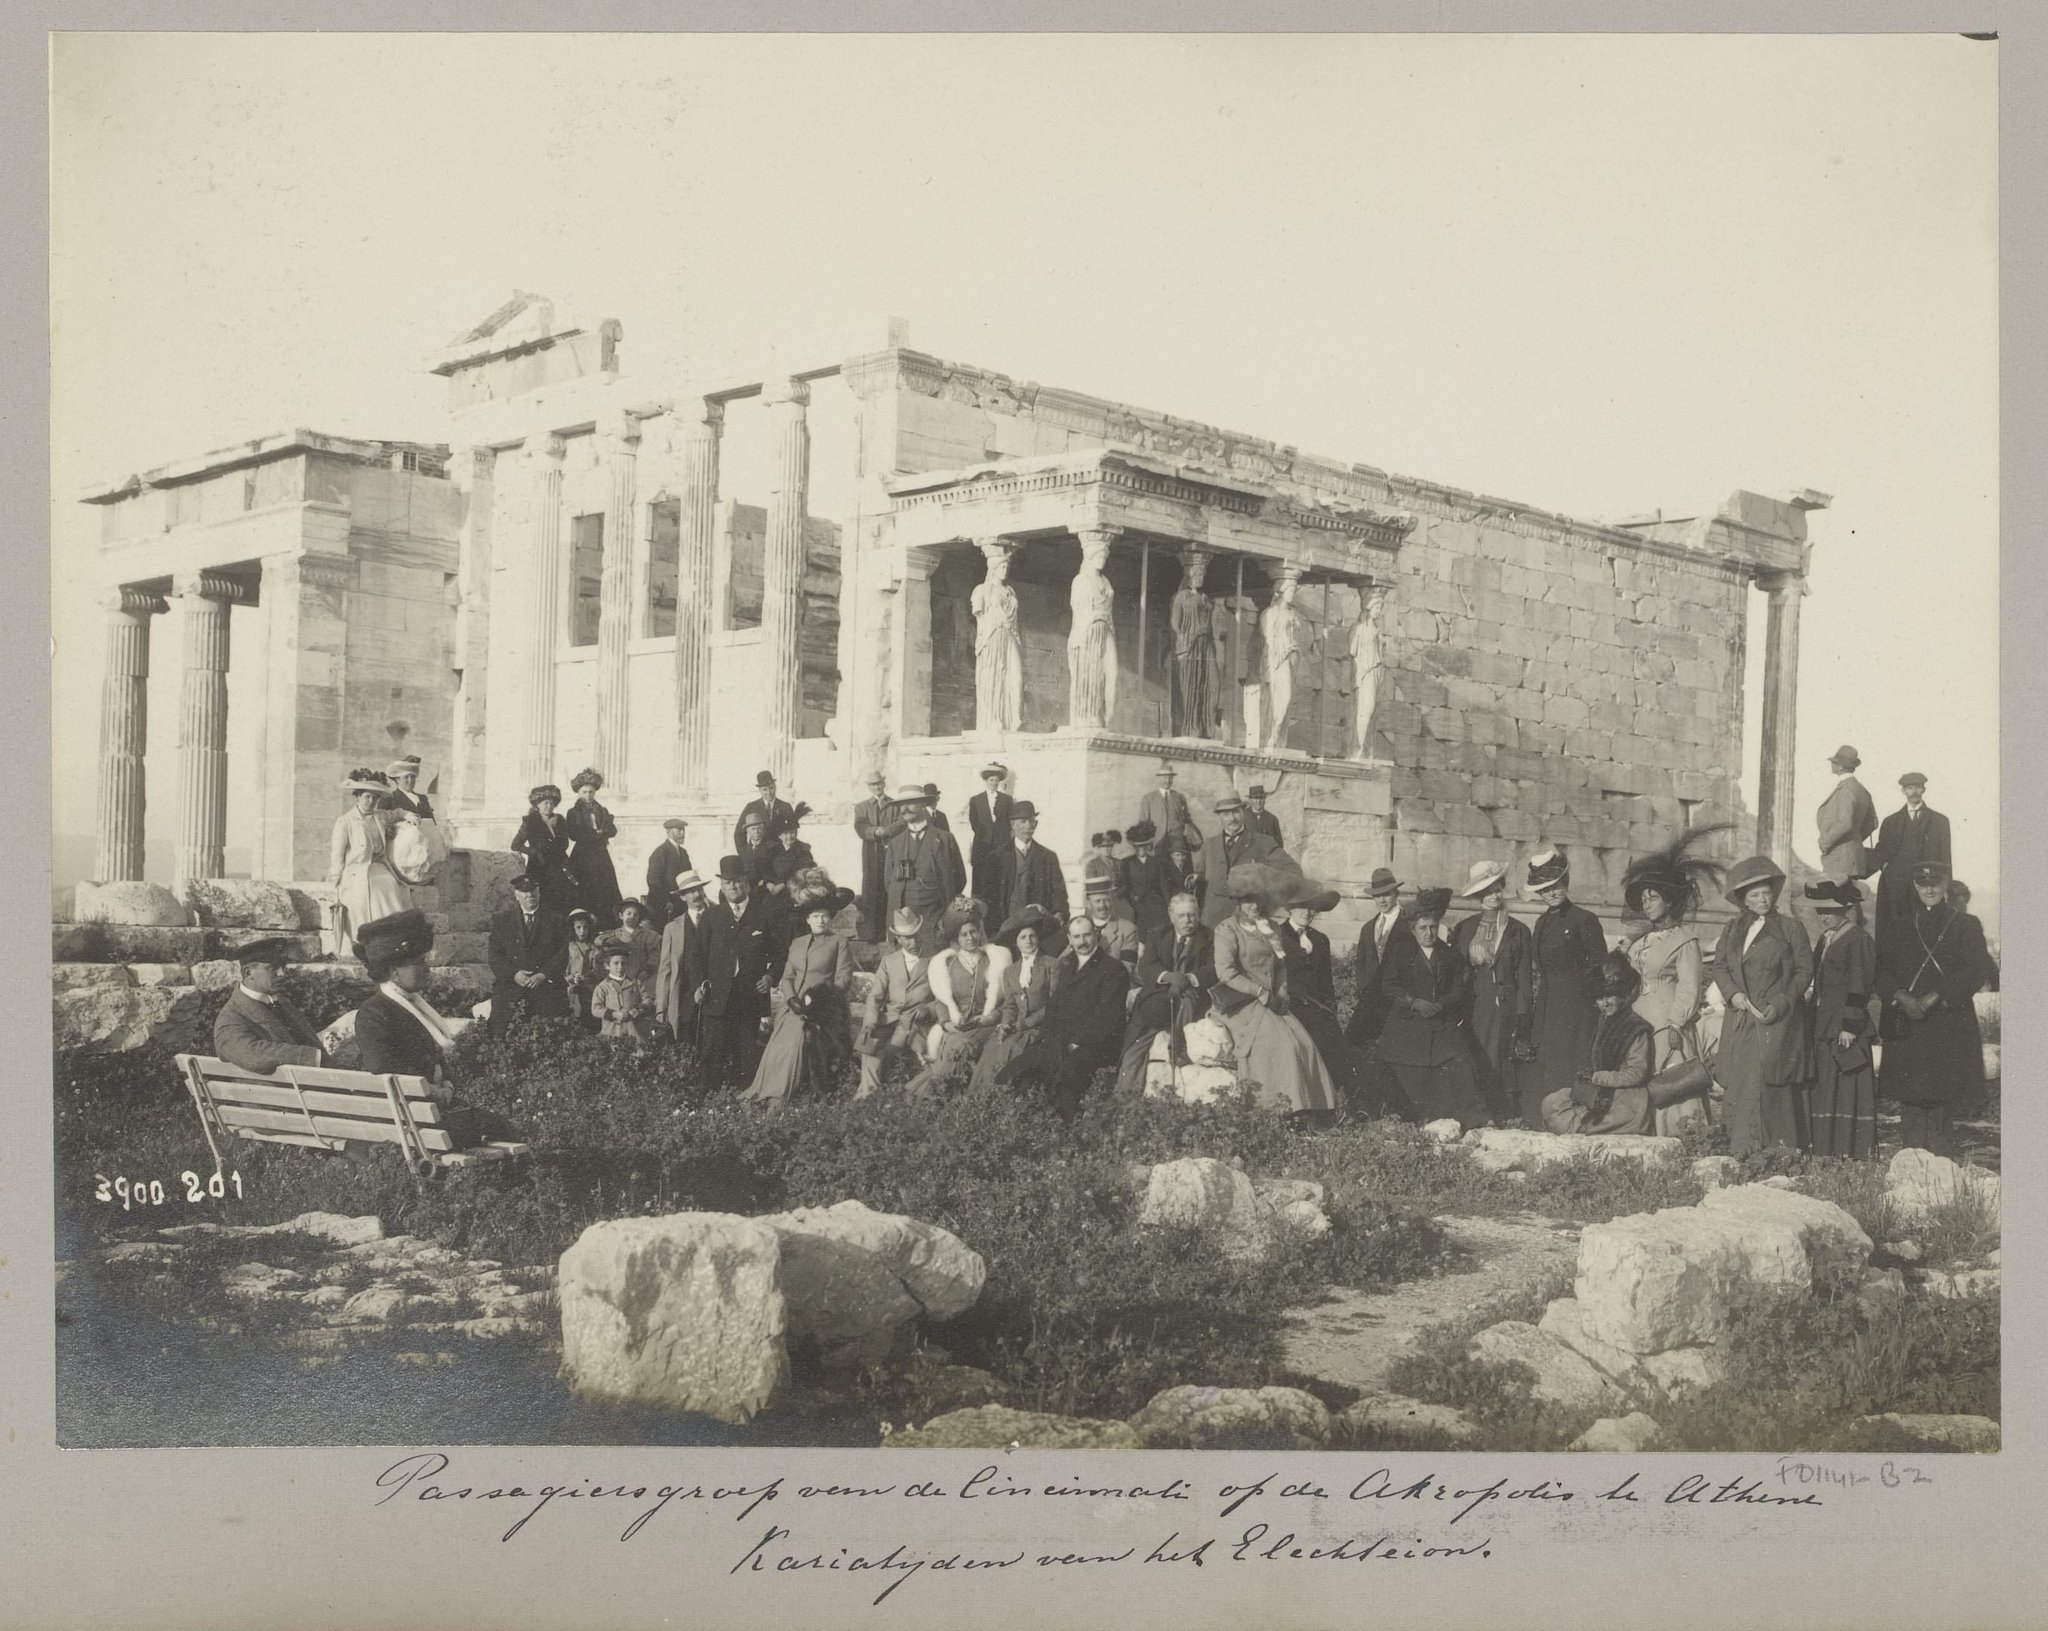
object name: photograph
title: Groepsportret van de passagiers van het schip 'Cincinnati' voor het Erechteion op de Akropolis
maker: Anonymous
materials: photographic support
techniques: gelatin silver print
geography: acropolis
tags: the family travelling, on holiday, temple, shrine ~ non-christian religions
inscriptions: number: ‘3900 201’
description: Onderdeel van Fotoalbum van een reis door Zuid-Europa en het Midden-Oosten.